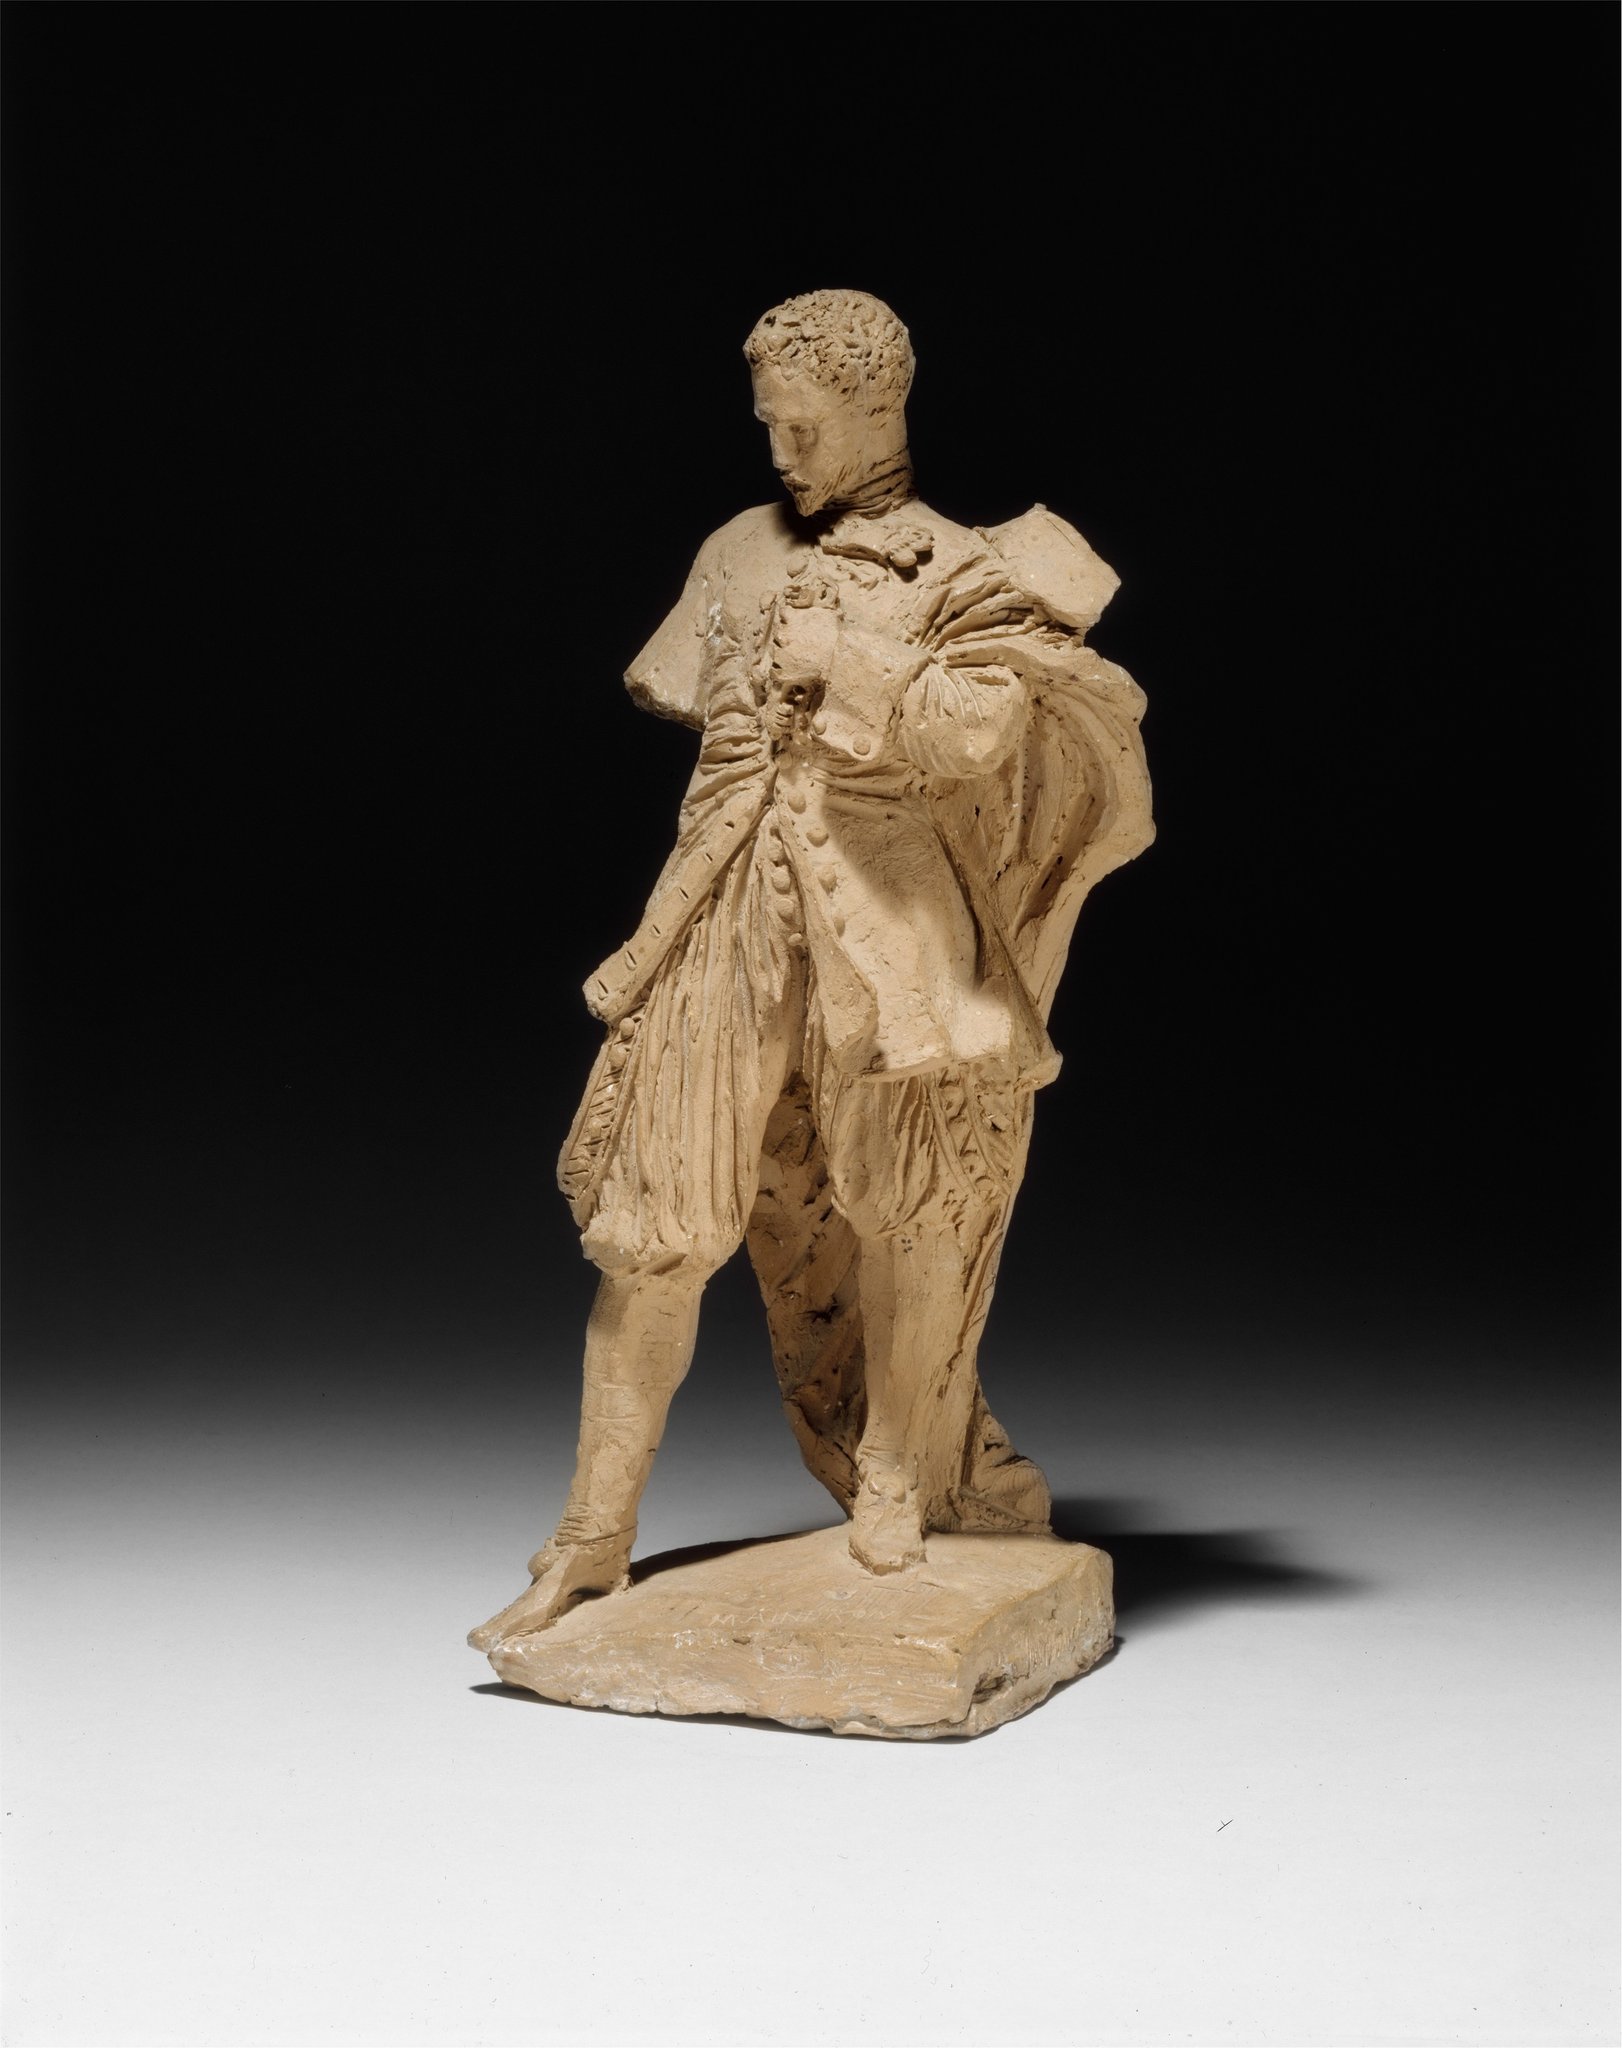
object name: model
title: Model for a statue of a hero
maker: etienne-hippolyte maindron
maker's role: artist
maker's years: 1801-1884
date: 1830-1840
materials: terracotta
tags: men